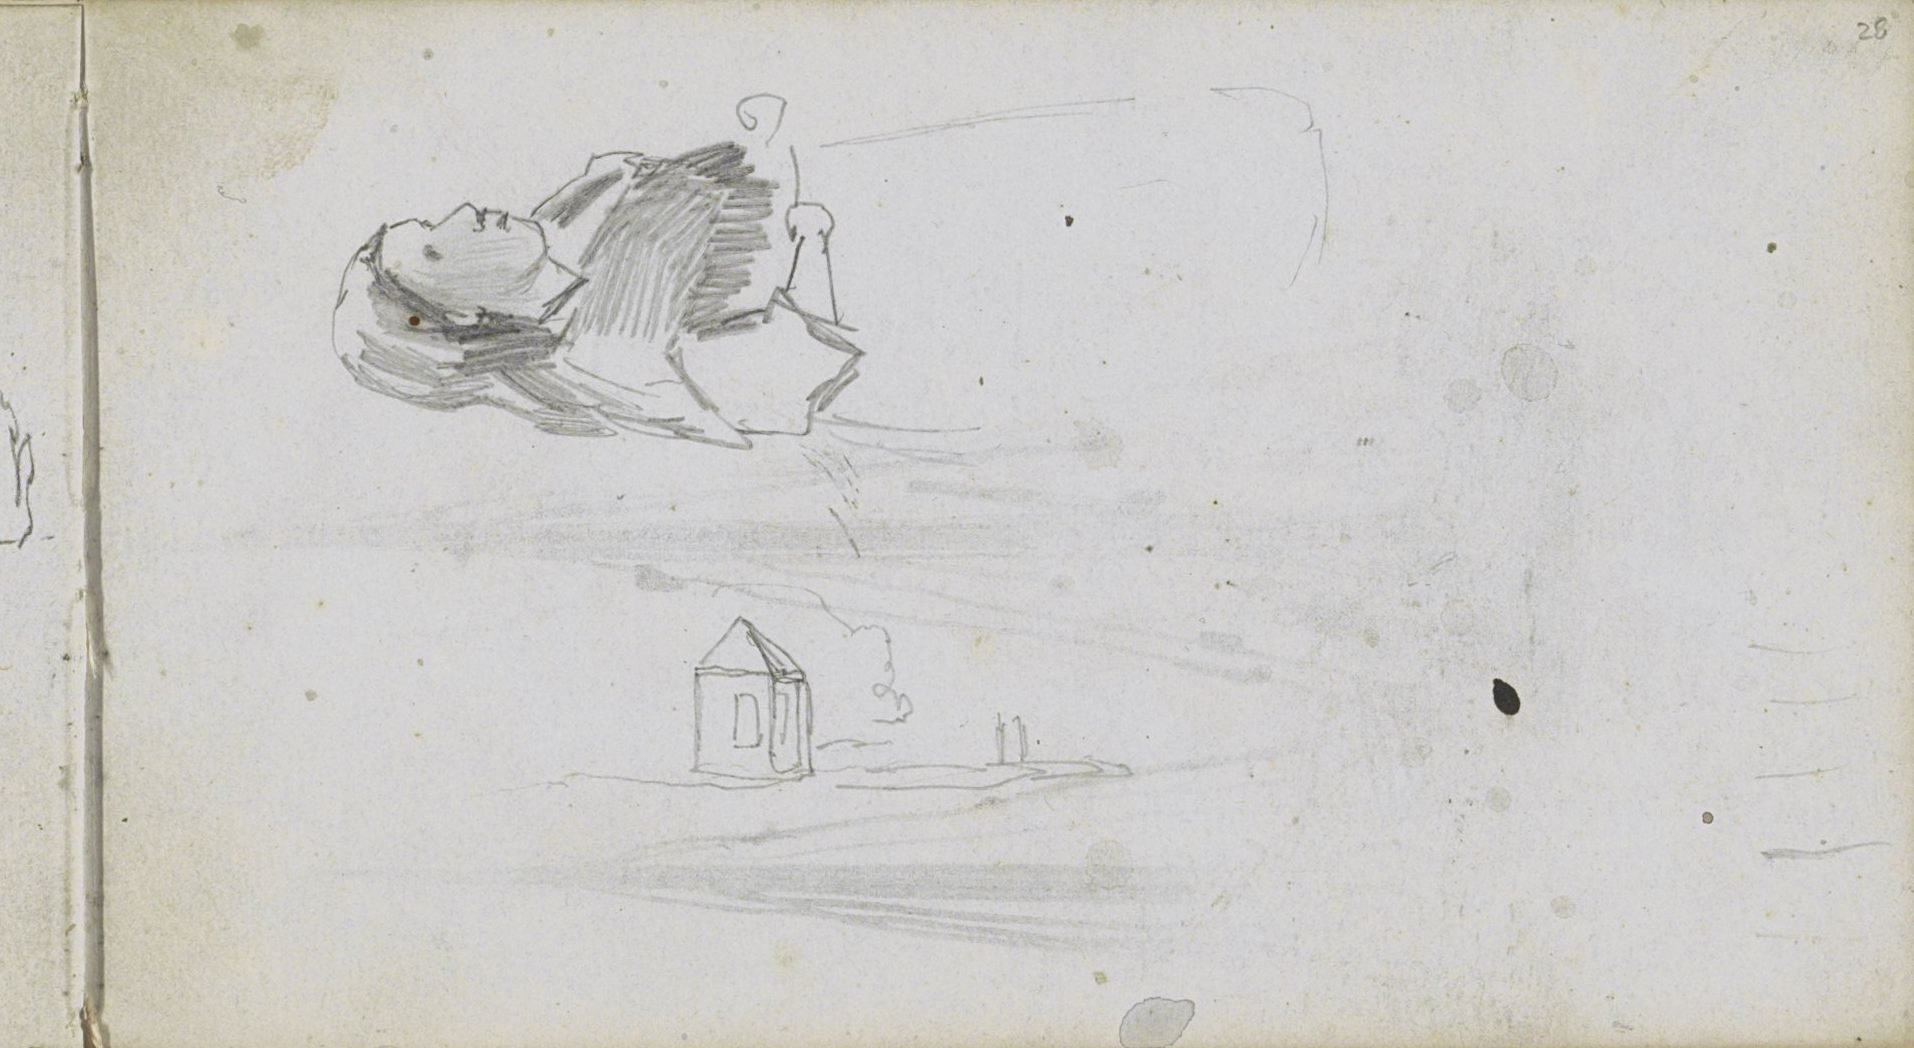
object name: sketchbook leaf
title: Huis in een landschap en een vrouw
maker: johan hendrik weissenbruch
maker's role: draughtsman, painter, print maker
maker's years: 1824-1903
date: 1834-1903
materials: paper, pencil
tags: adult woman, farm or solitary house in landscape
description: Blad 28 recto uit een schetsboek met 39 bladen.